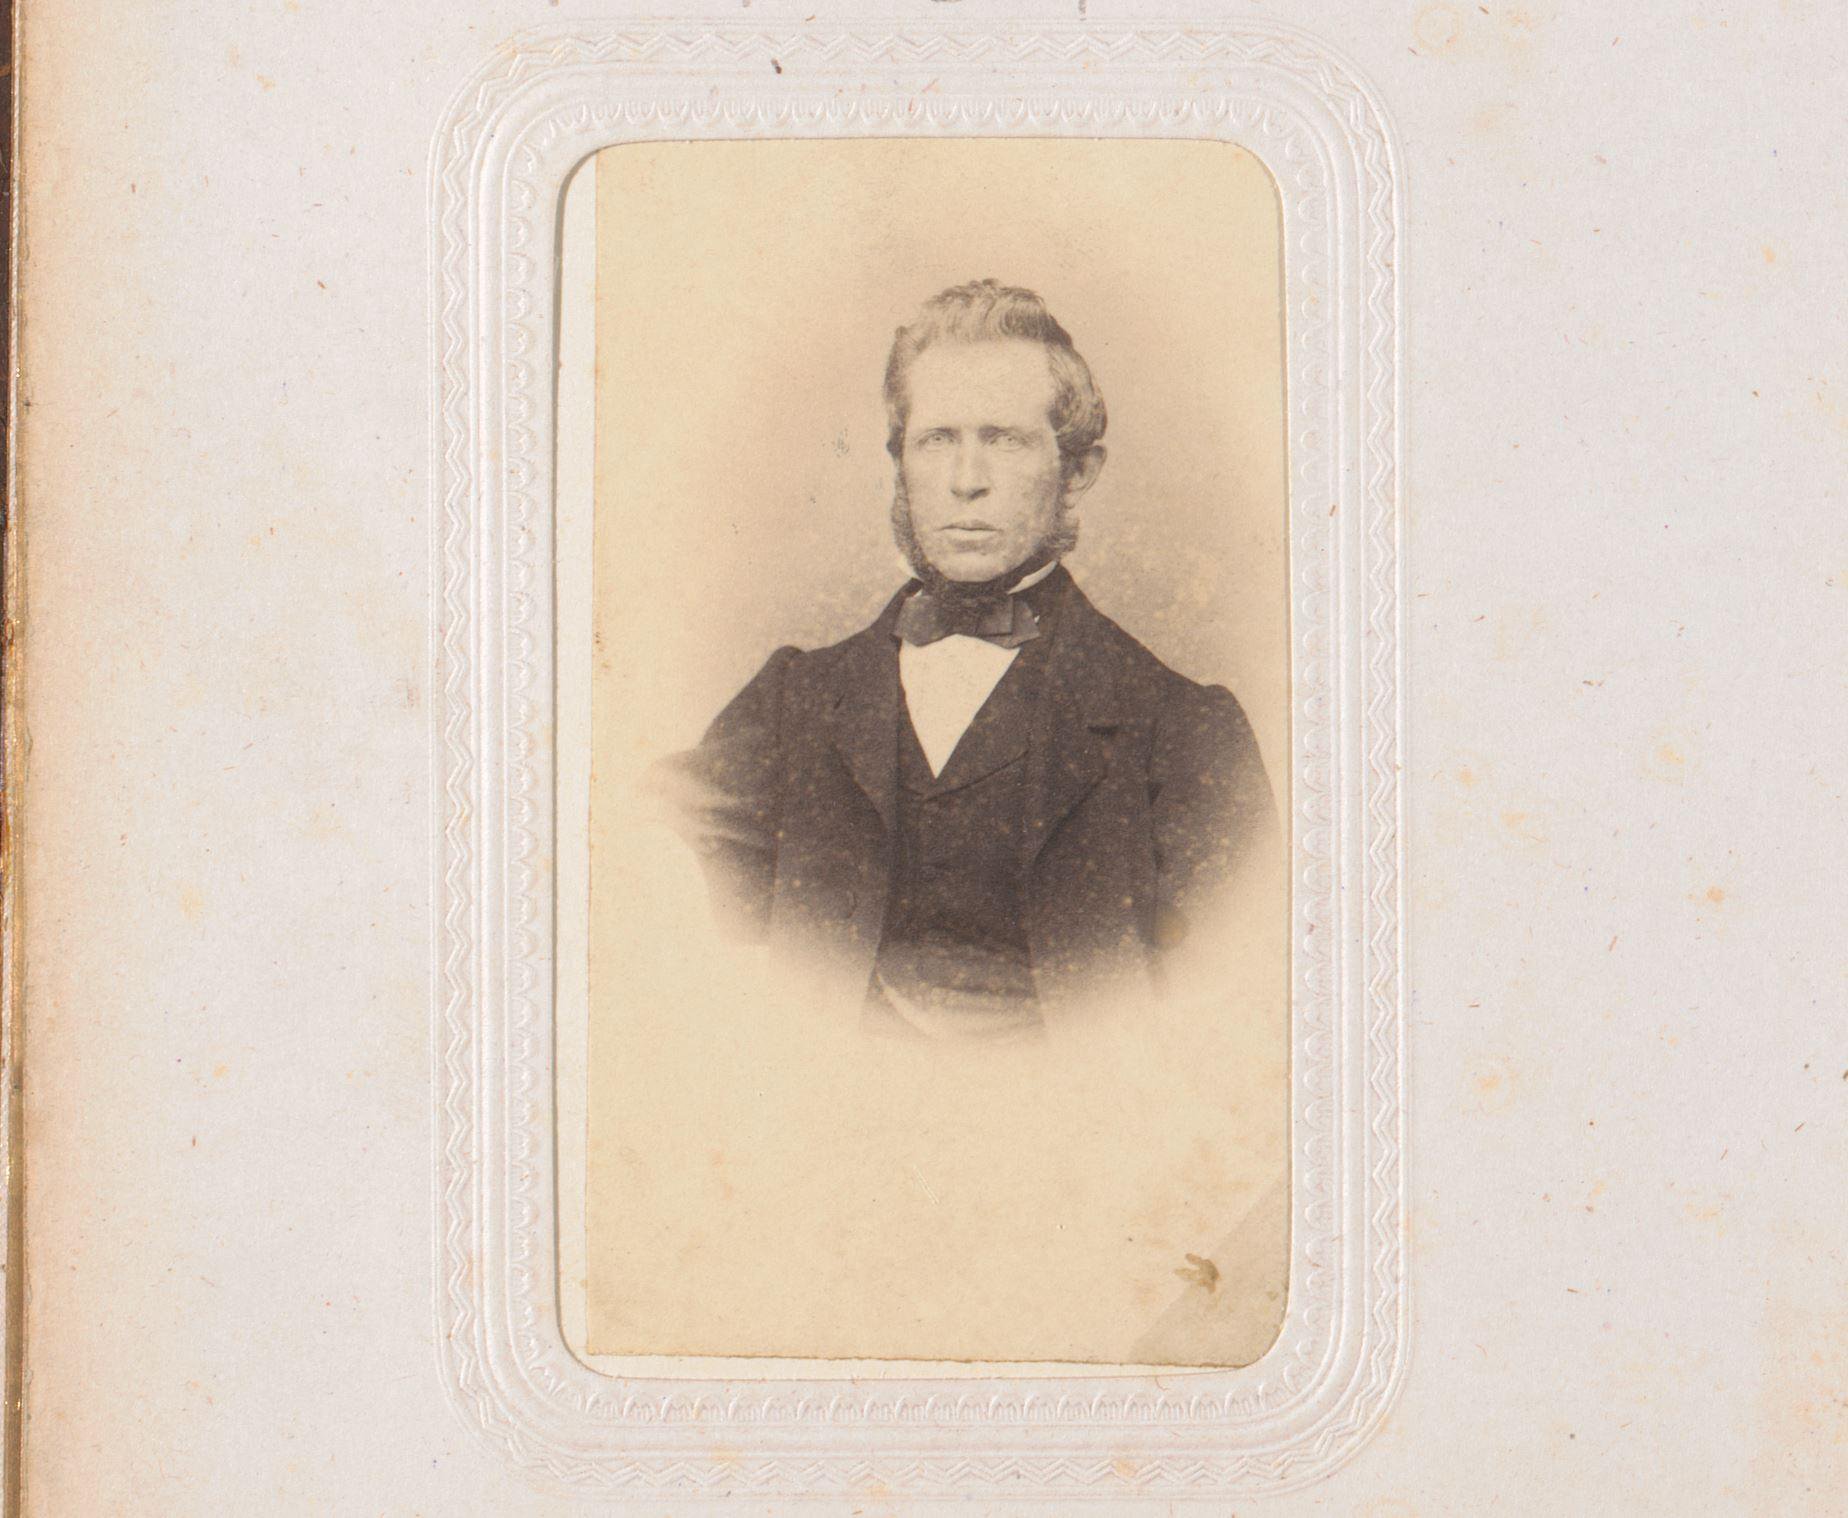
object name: photograph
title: Portret van een man, aangeduid als Geertsema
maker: jacobus van koningsveld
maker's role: draughtsman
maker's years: 1824-1866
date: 1850-1866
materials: cardboard, photographic support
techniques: albumen print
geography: the hague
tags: historical persons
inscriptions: signature: ‘[.]Geertsema’, name: ‘Geertsema’, inscription: ‘J. v. Koningsveld/ FREDERIKSTRAAT 60.’